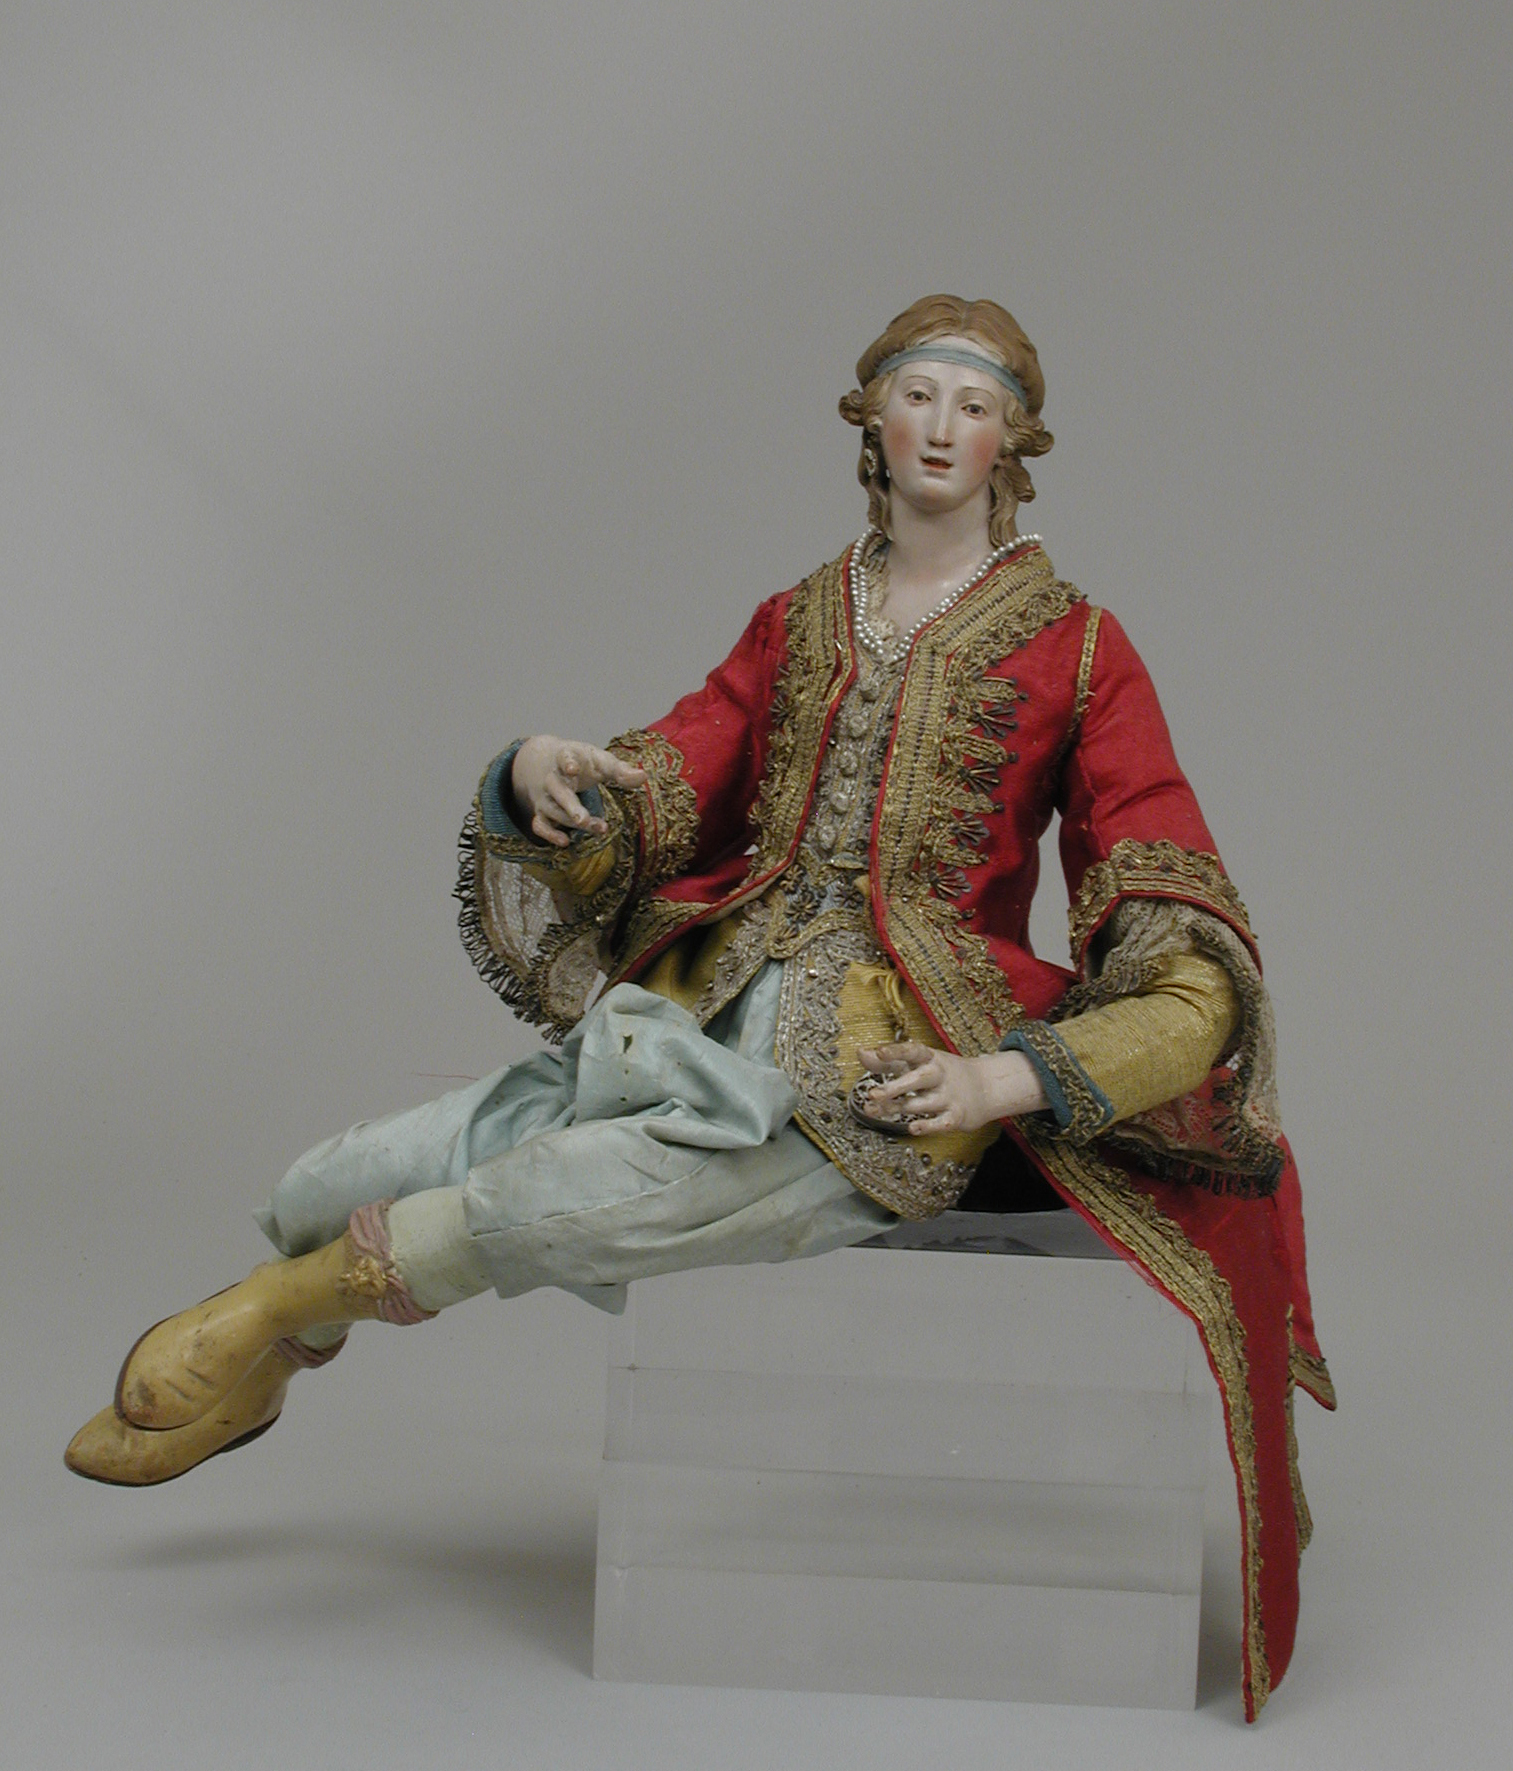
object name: crèche figure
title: Lady with silver basket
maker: giuseppe gori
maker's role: maker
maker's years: 1770-1810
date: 1751-1800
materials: gold, lace, pearl, textile, silk, silver, thread, terracotta, fiber, velvet, metal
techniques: filigree, polychrome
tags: women